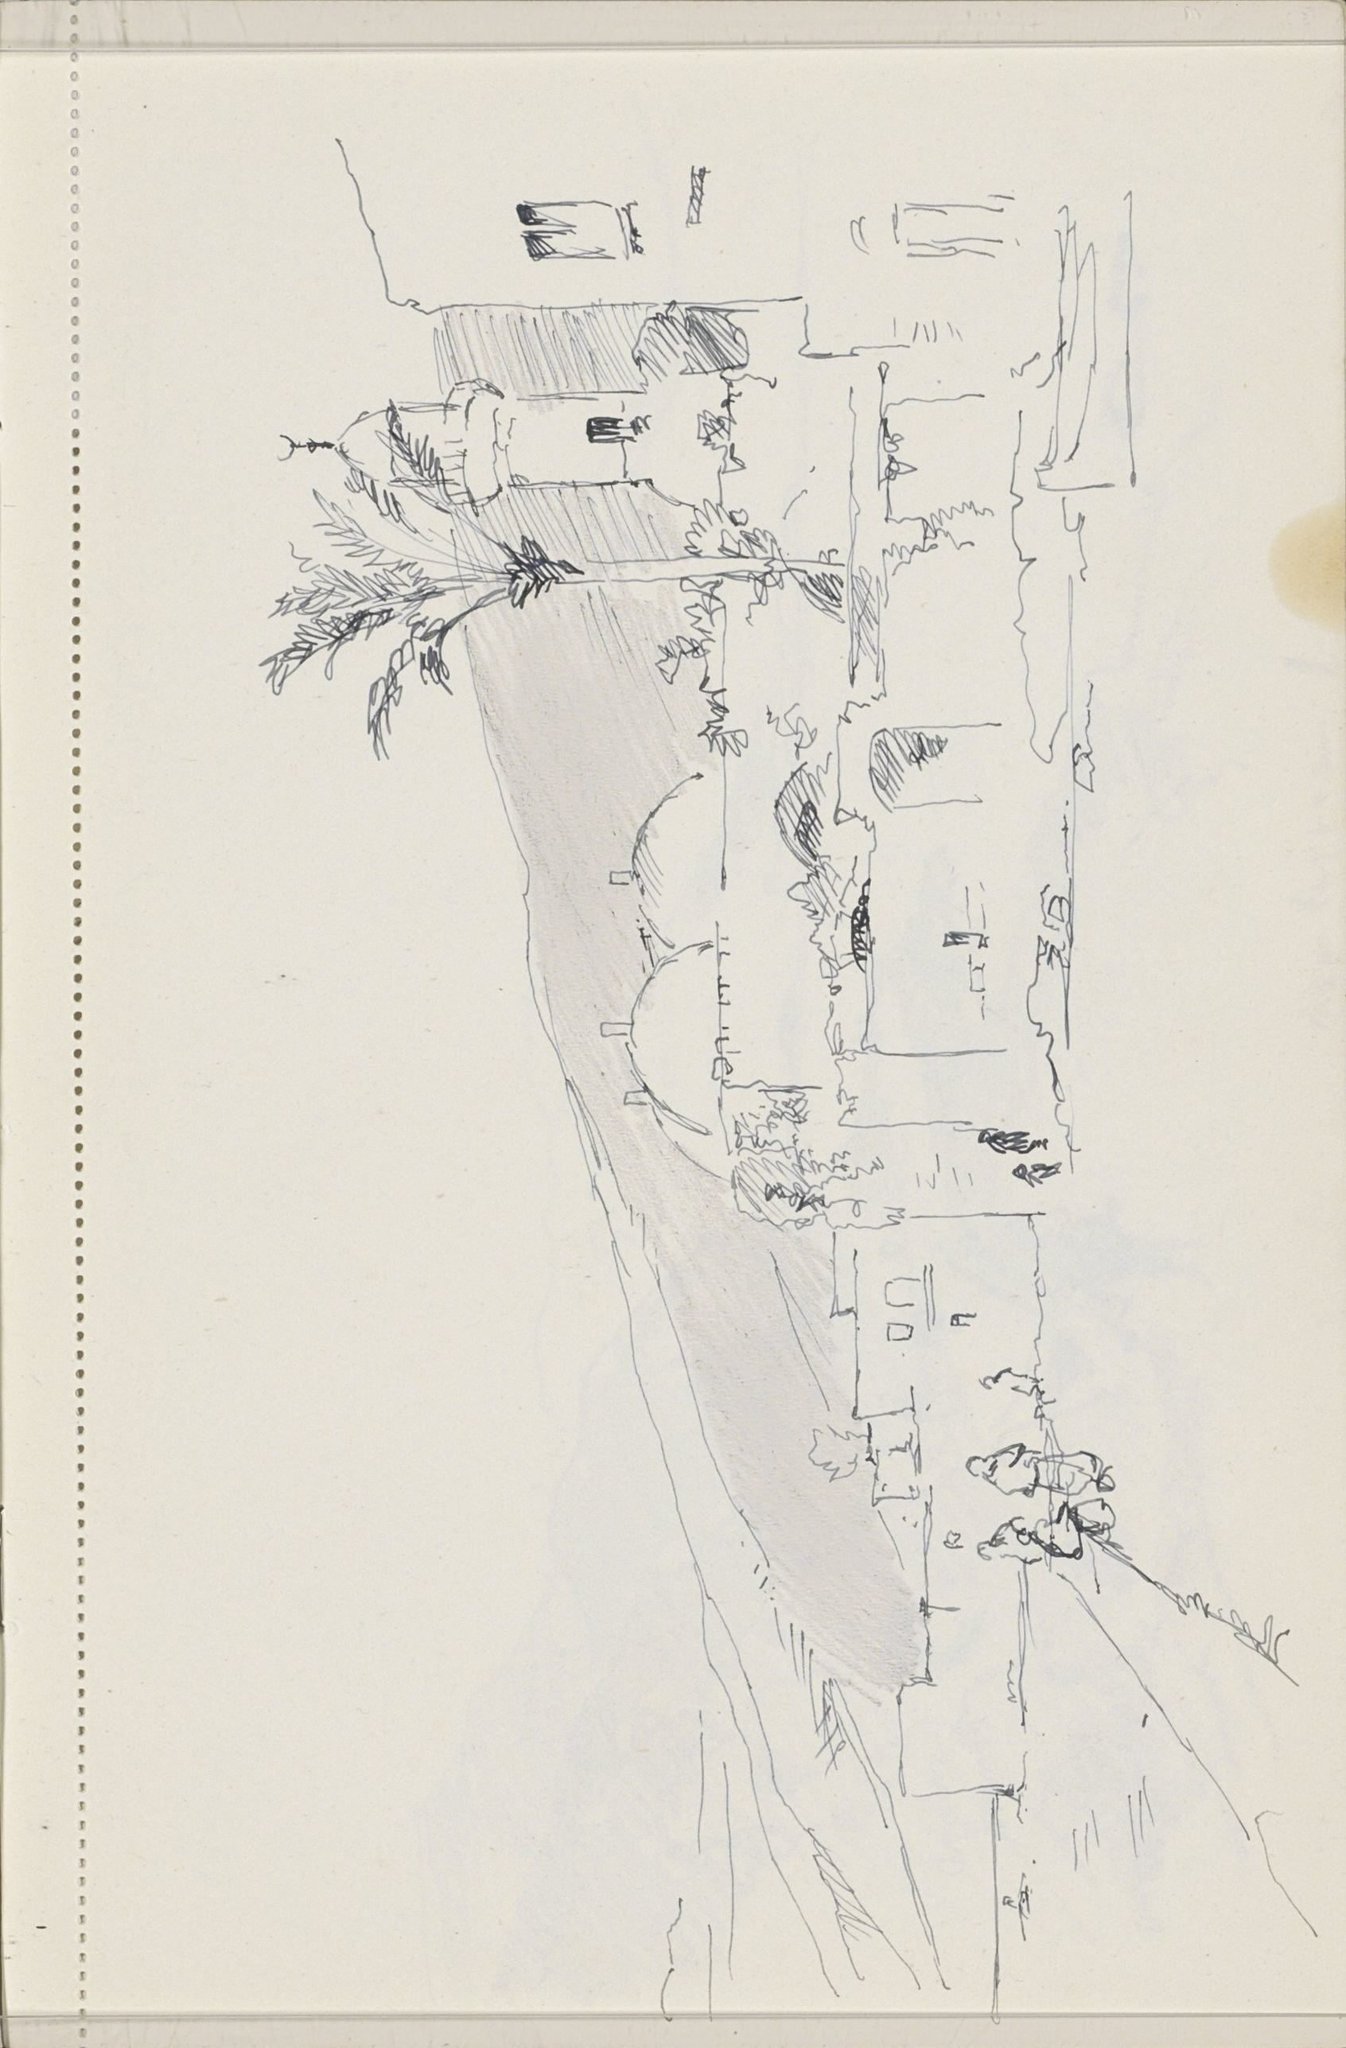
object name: sketchbook leaf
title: Boulevard van een oosters dorp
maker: cornelis vreedenburgh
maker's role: draughtsman, print maker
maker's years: 1880-1946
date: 1936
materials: ink, paper, pencil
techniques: pen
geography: maghreb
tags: avenue, boulevard, promenade, esplanade, street (+ city(-scape) with figures, staffage)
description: Op de achtergrond de koepels en minaret van een moskee en een palmboom. Blad 43 recto uit een schetsboek met 73 bladen.